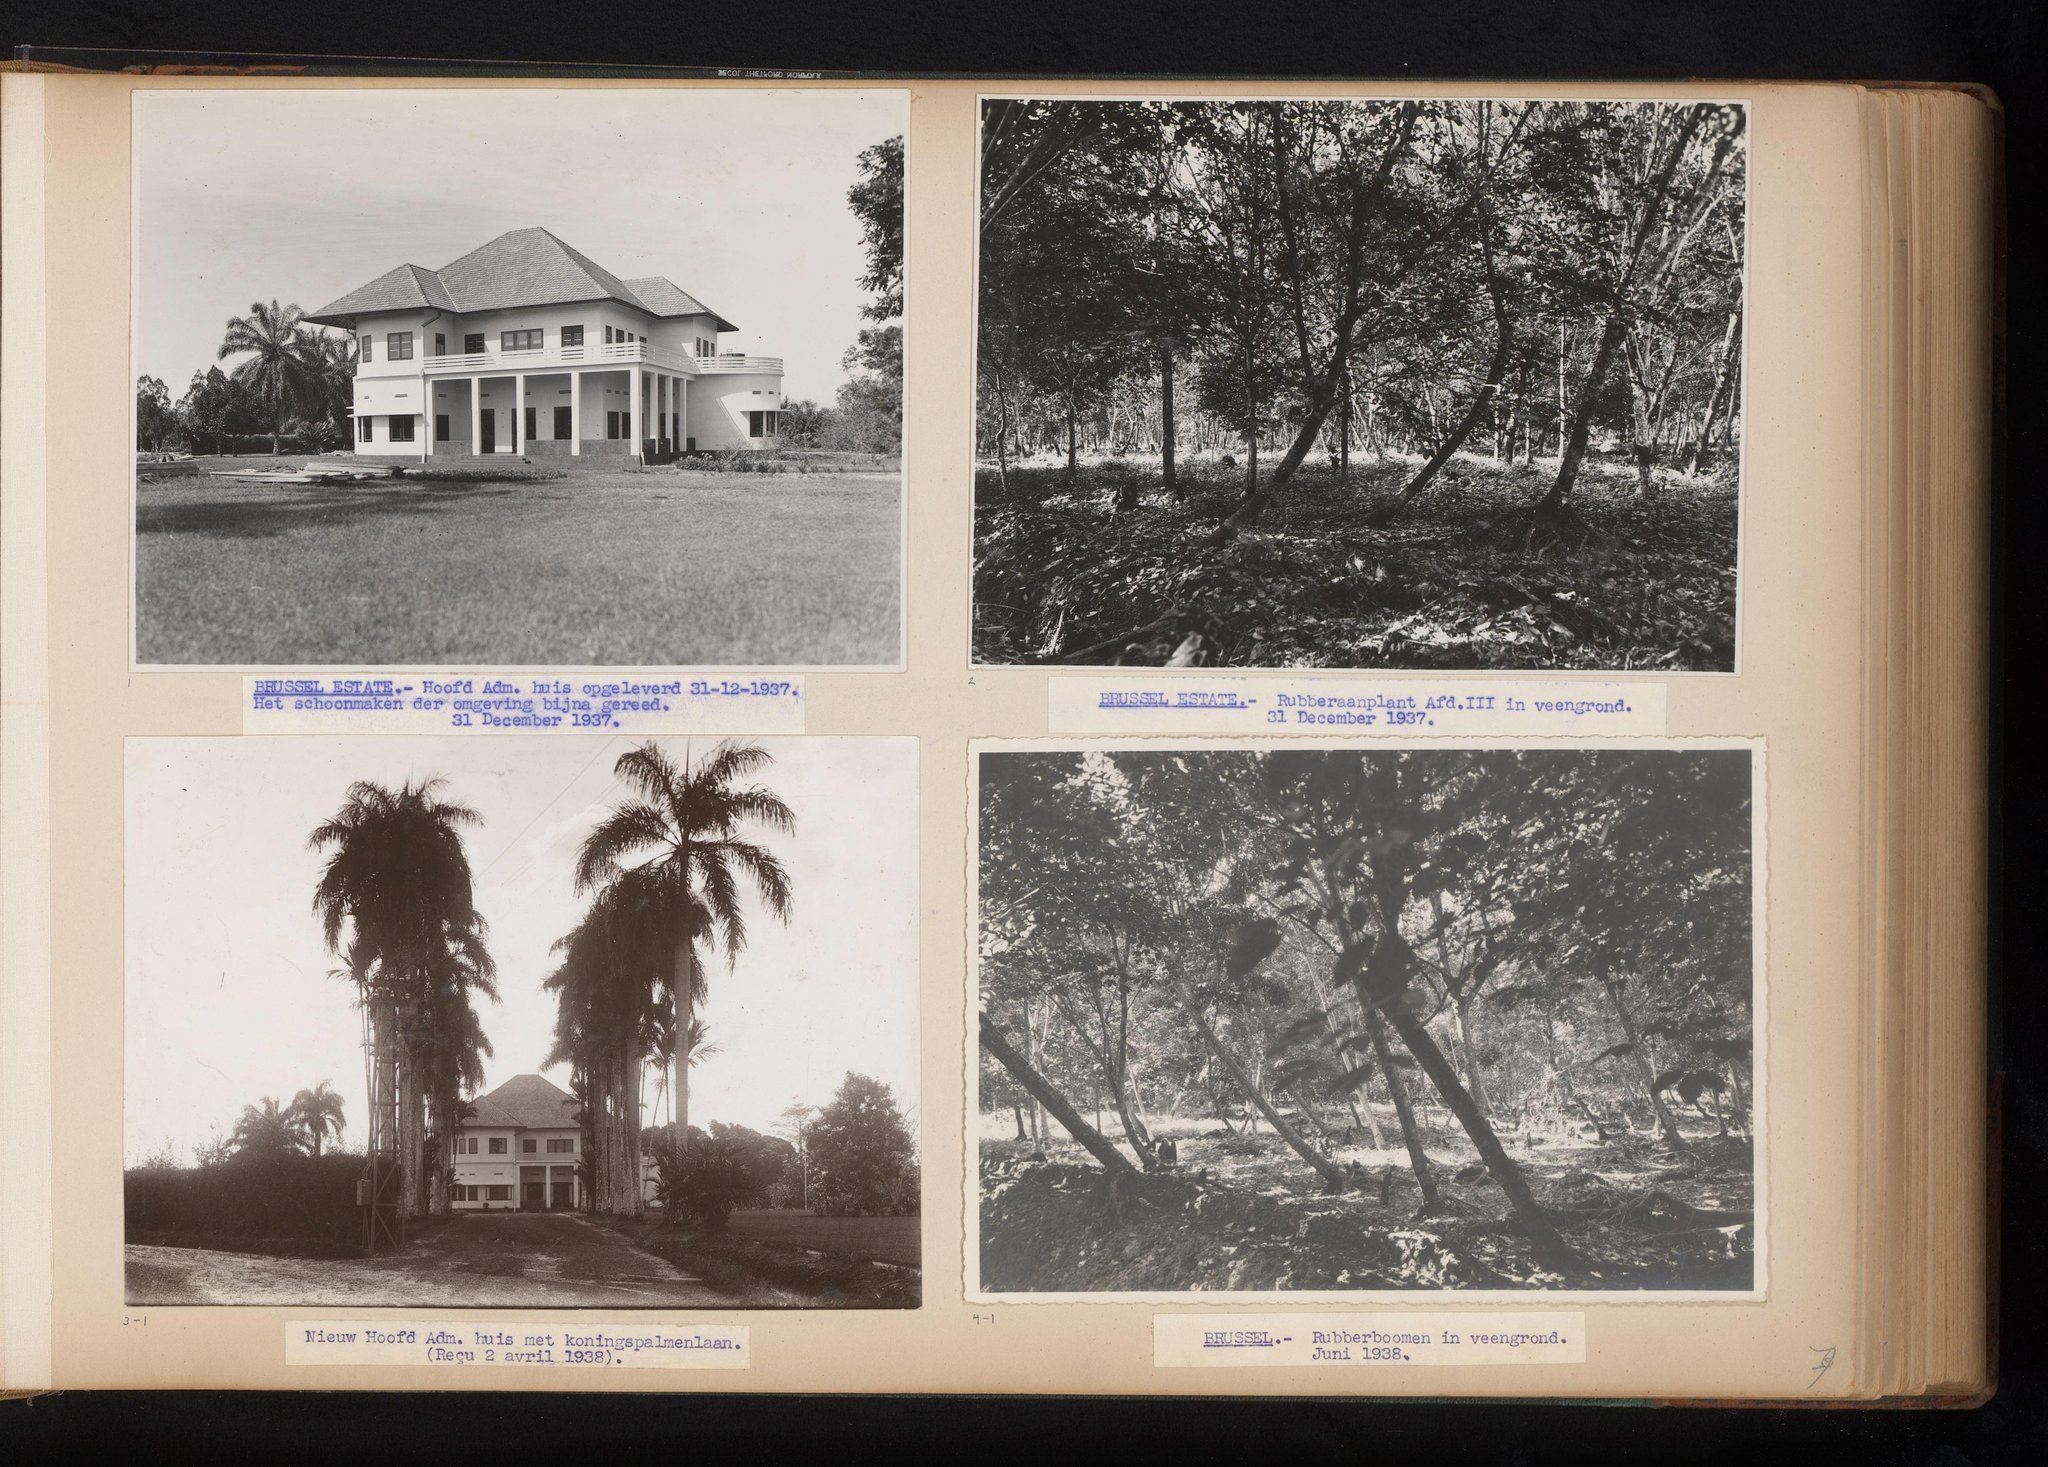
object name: photograph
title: Bedrijfswoning en rubberbomen op Brussel, 1937-1938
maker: Anonymous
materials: cardboard, photographic support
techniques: gelatin silver print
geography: sumatra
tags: plantation, (non-fruit) products of plants or trees: rubber, villa, sumatra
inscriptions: inscription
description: Blad met vier foto's de nieuwe woning voor de hoofdadministrateur en rubberbomen op Brussel, 1937-1938. Met etiketten met onderschriften onder de foto's. Onderdeel van het fotoalbum over de plantages Pernantian en Brussel van de Sumatra Caoutchouc Maatschappij op de Oostkust van Sumatra in de jaren 1935-1939.